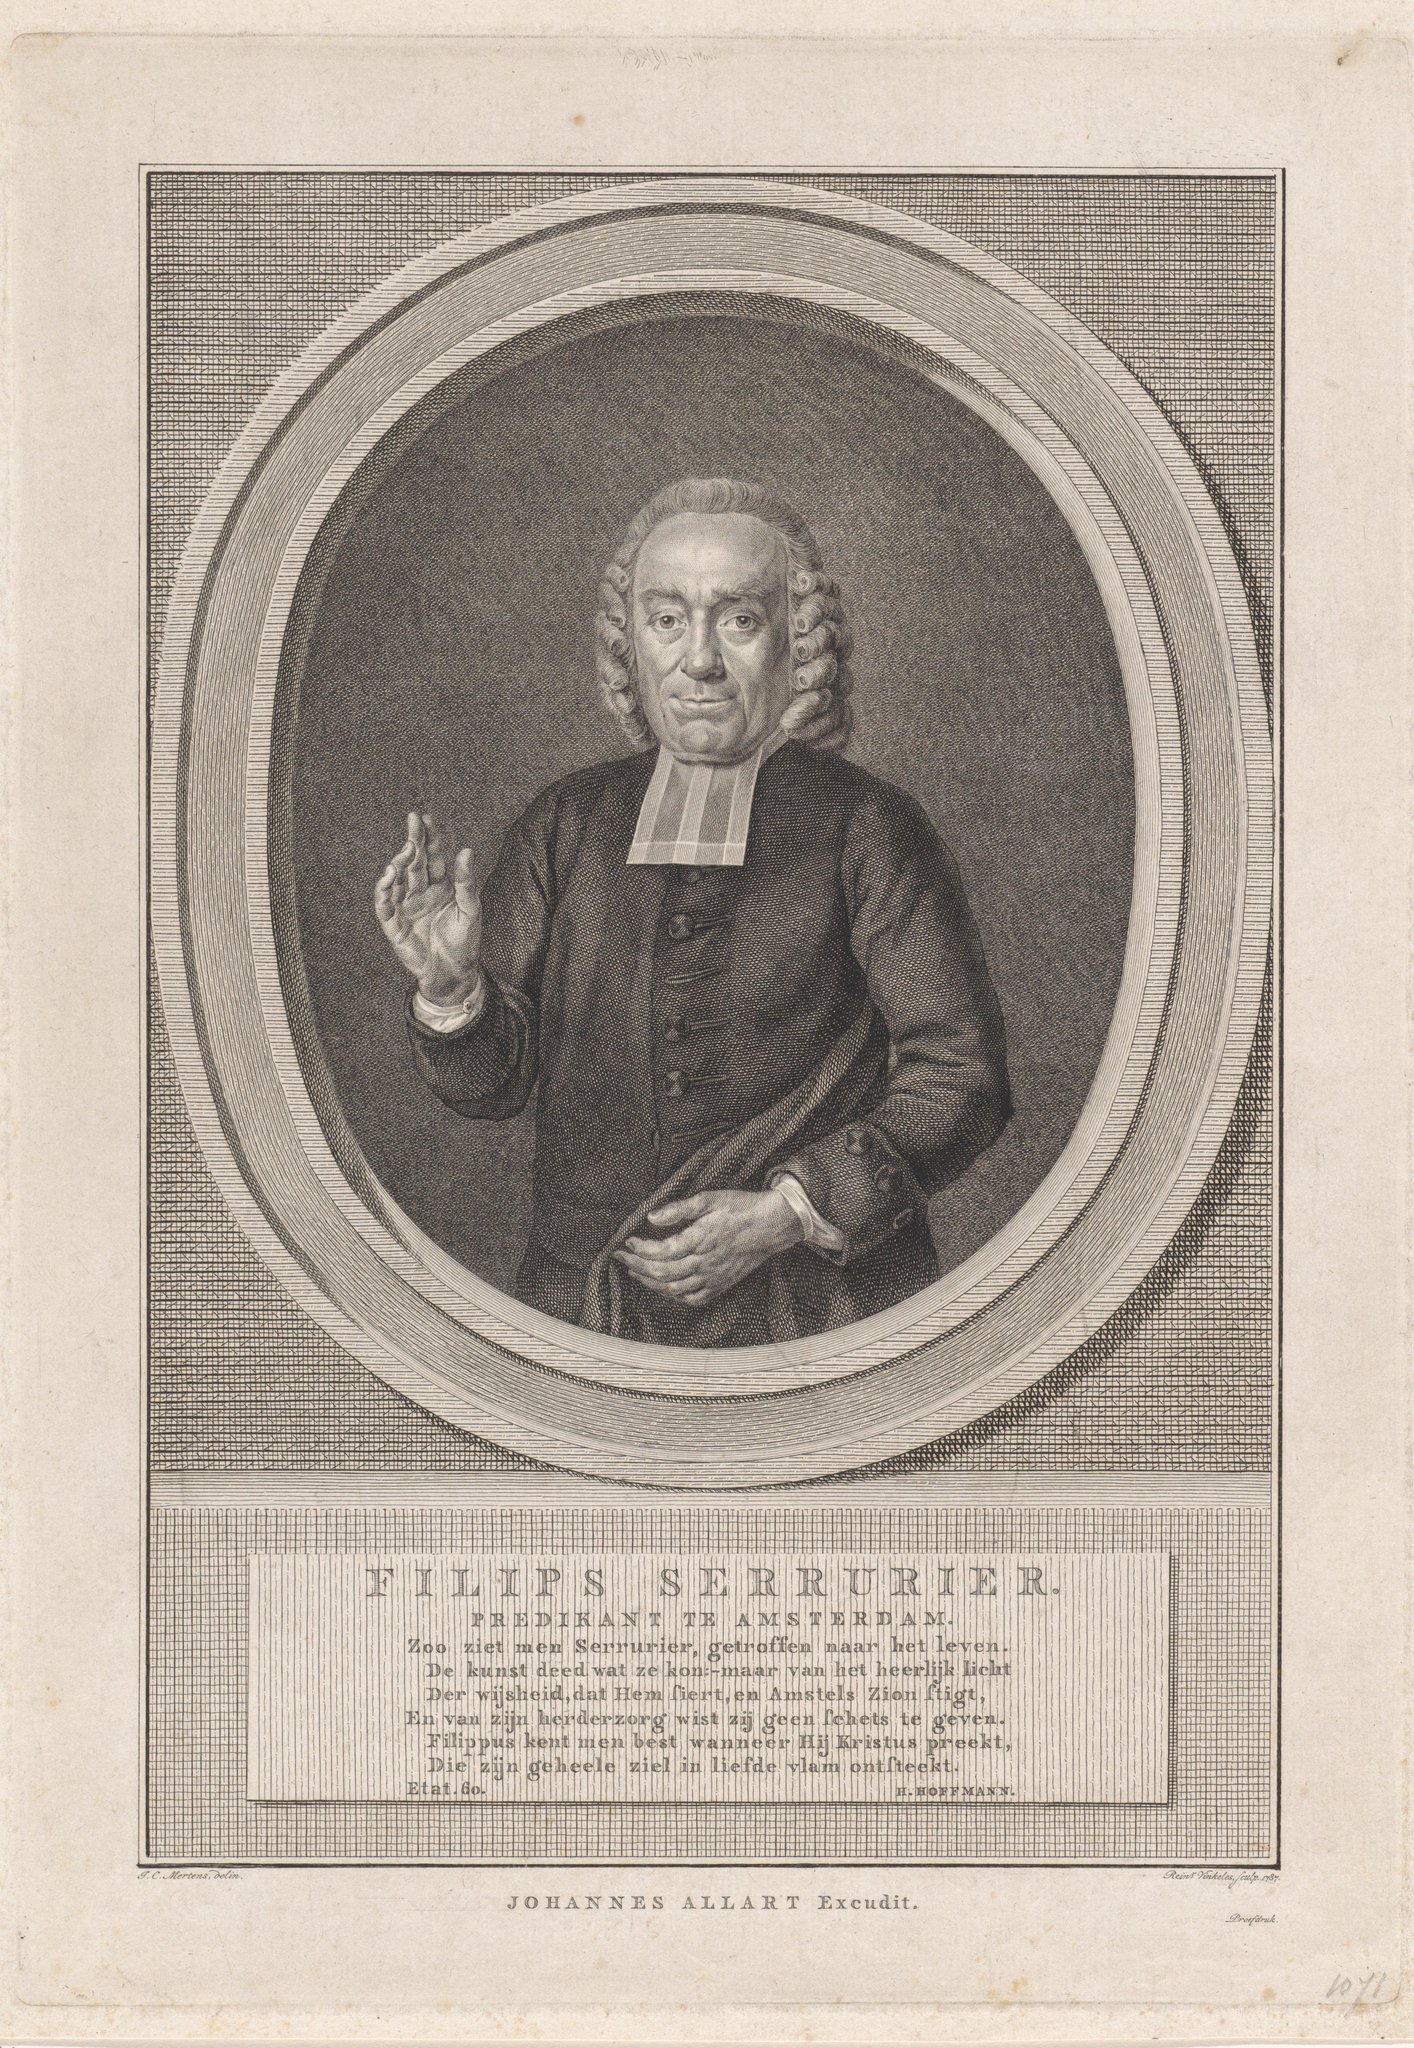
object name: print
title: Portret van de predikant Philippus Serrurier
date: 1787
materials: paper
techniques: engraving, etching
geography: amsterdam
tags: predikant, phillipus serrurier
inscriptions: collector's mark: Lugt 2228